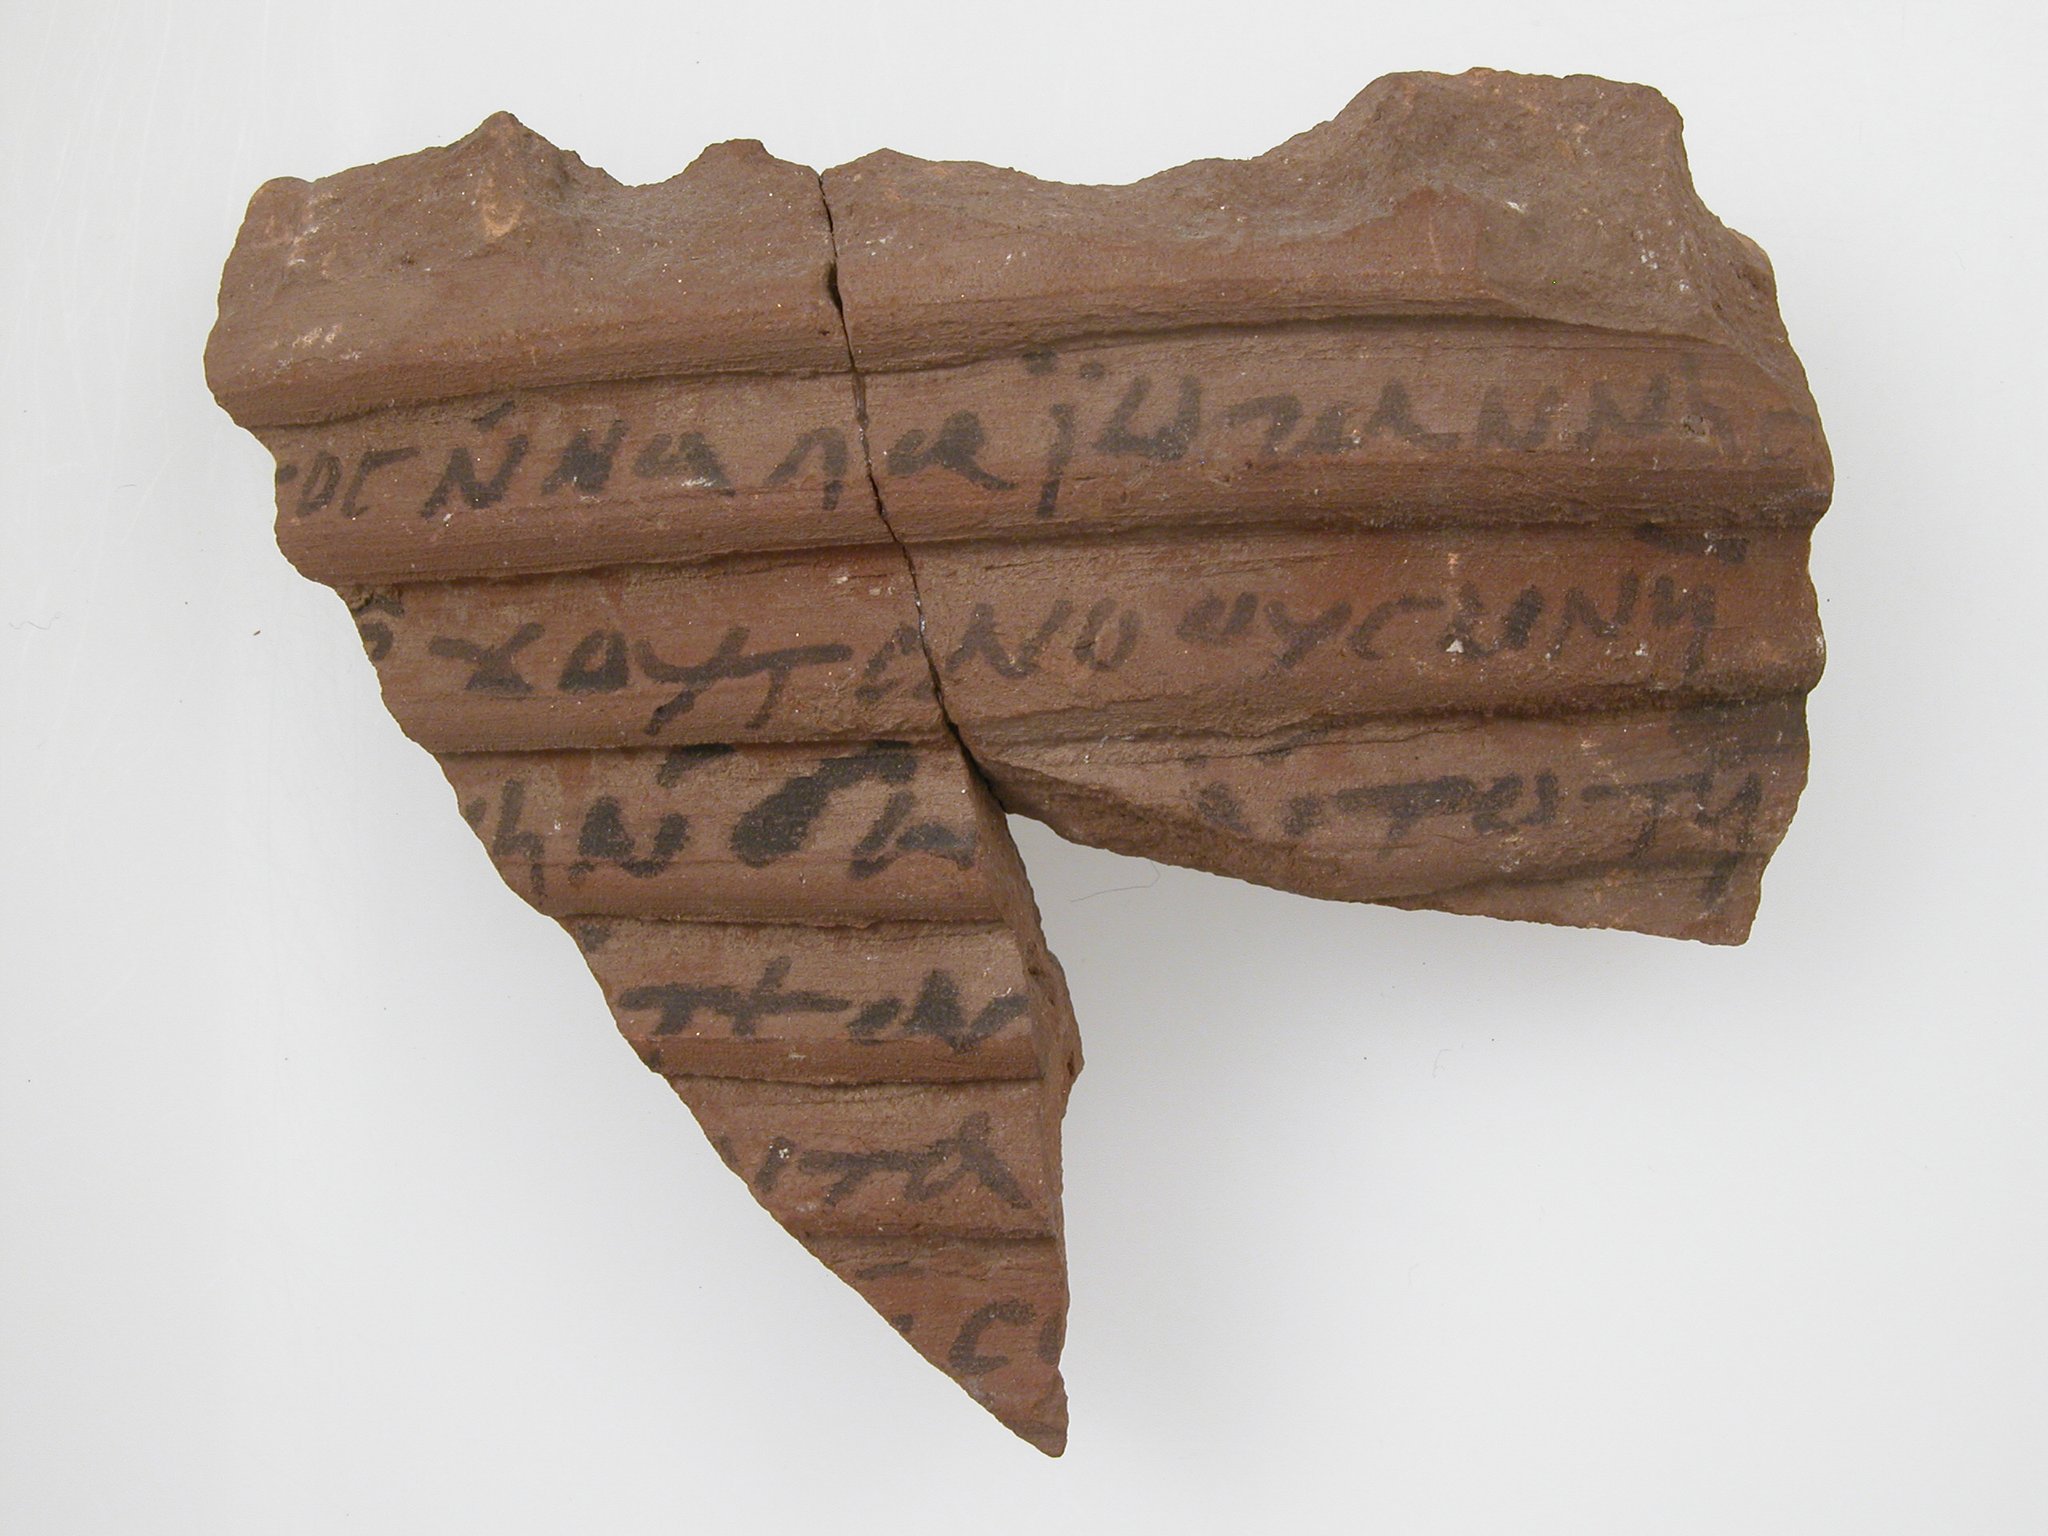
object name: ostrakon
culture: coptic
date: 601-700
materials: ink, pottery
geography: egypt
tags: documents